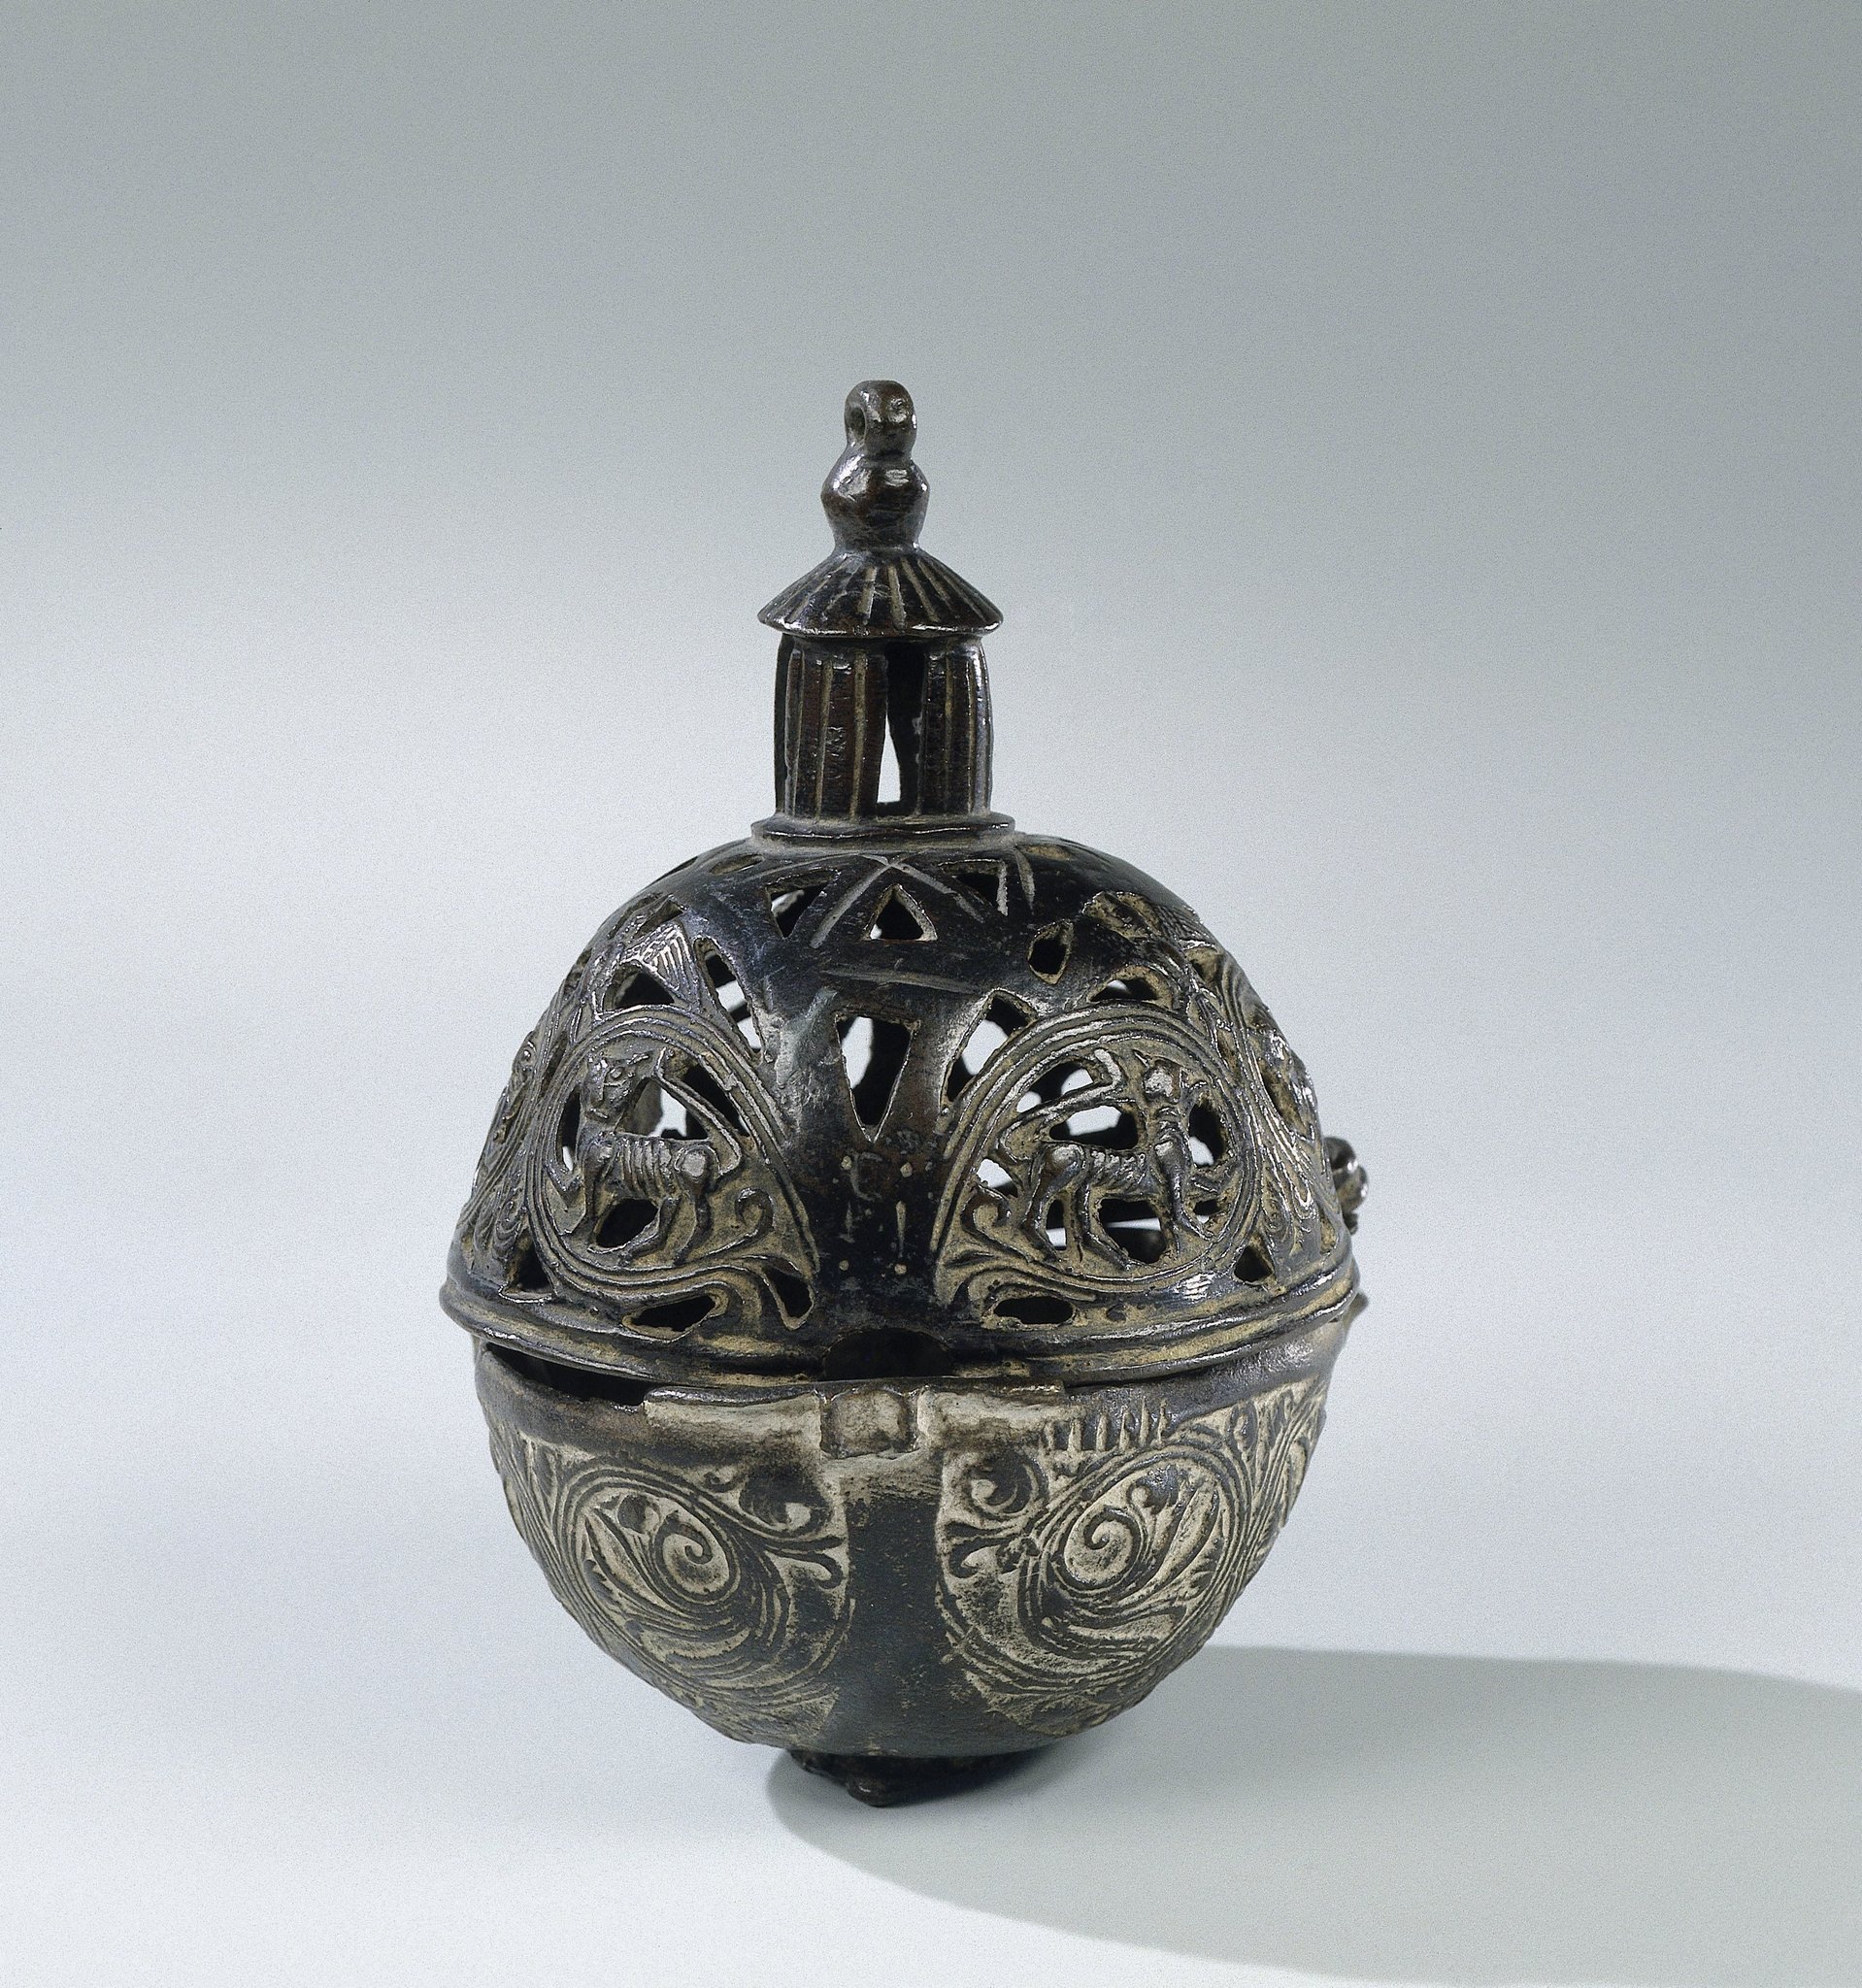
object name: censer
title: Wierookvat, bolvormig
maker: Anonymous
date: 1150-1200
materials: bronze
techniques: casting, embroidery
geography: western europe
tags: ornament derived from animal forms, foliage, tendrils, branches ~ ornament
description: Censer. Bronze. Western Europe, c. 1150 - 1200.